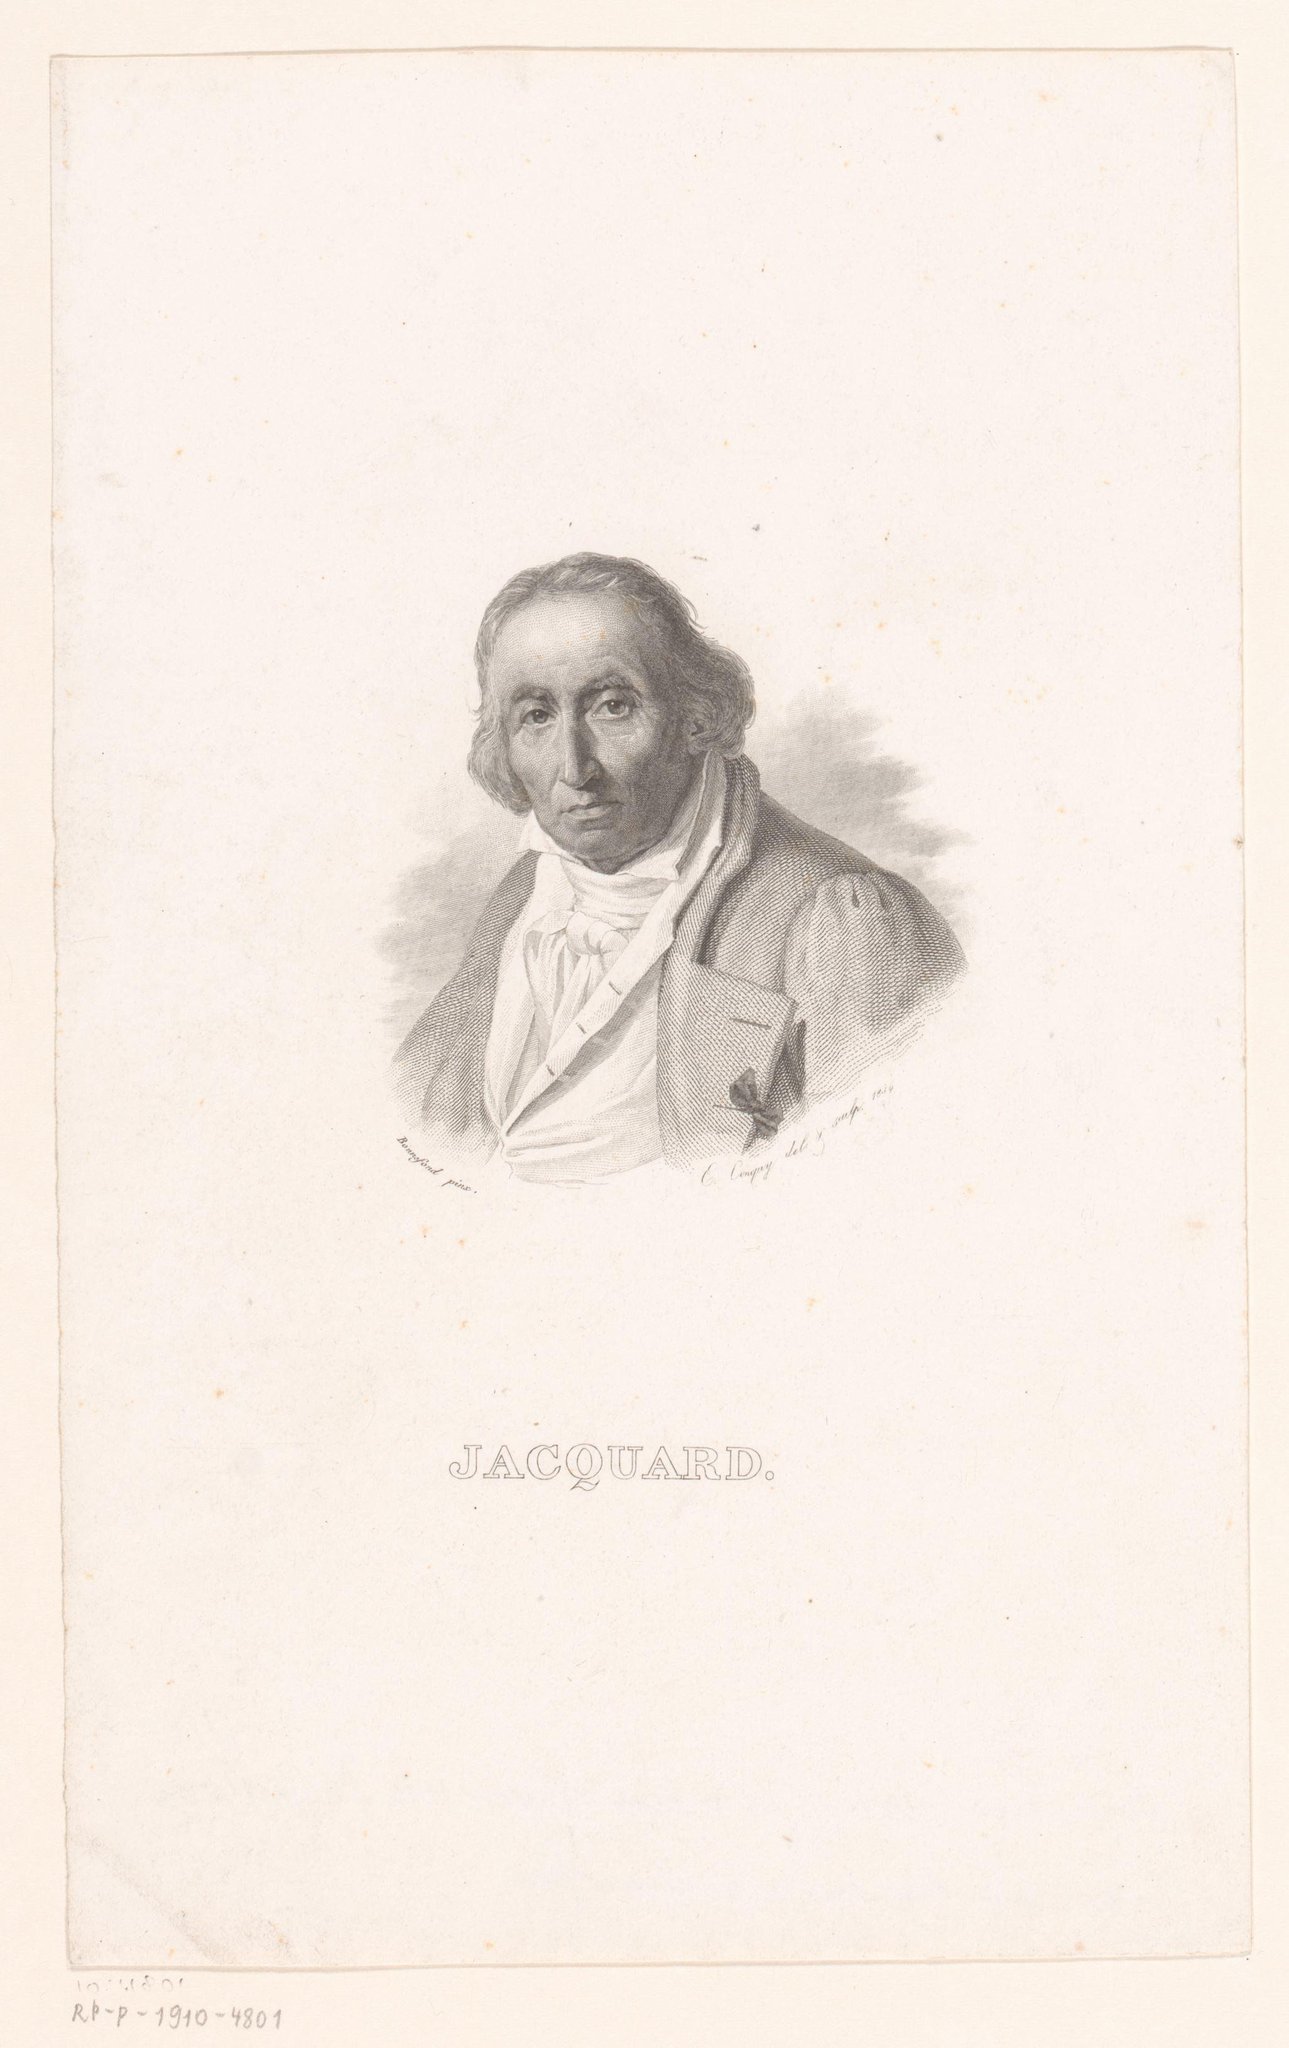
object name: print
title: Jacquard.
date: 1834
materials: paper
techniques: engraving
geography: france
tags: lyon, joseph marie jacquard, historical persons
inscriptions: collector's mark: Lugt 2228